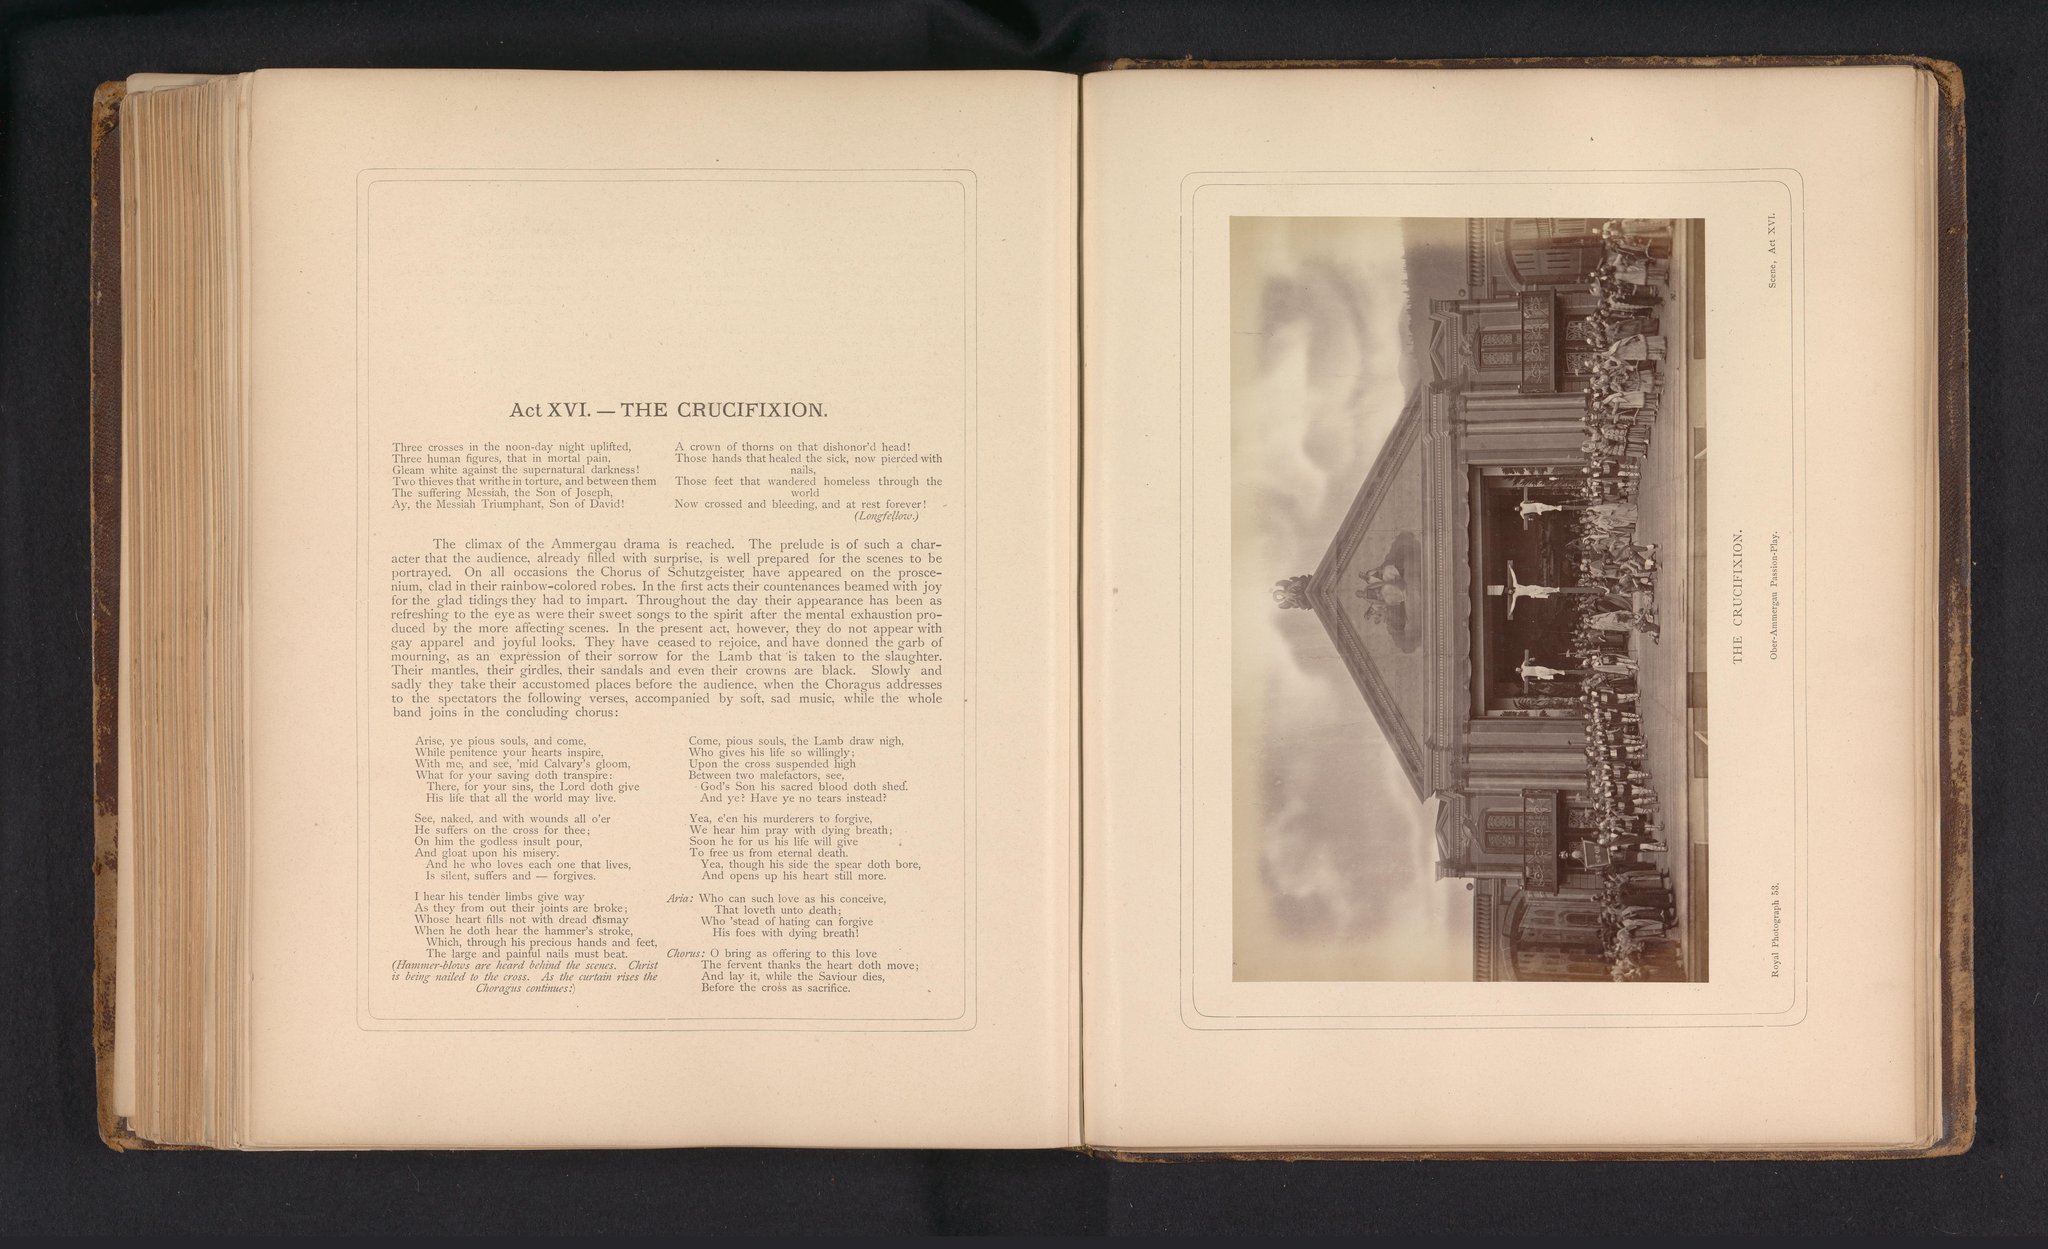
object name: photograph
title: The crucifixion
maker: joseph albert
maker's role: printer, publisher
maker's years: 1825-1886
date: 1868-1873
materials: photographic support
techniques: albumen print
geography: oberammergau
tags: group of actors, troupe; actors on the stage, the crucifixion of christ: christ's death on the cross; golgotha (matthew 27:45-58; mark 15:33-45; luke 23:44-52; john 19:25-38)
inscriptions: number: ‘Royal Photograph 53.’